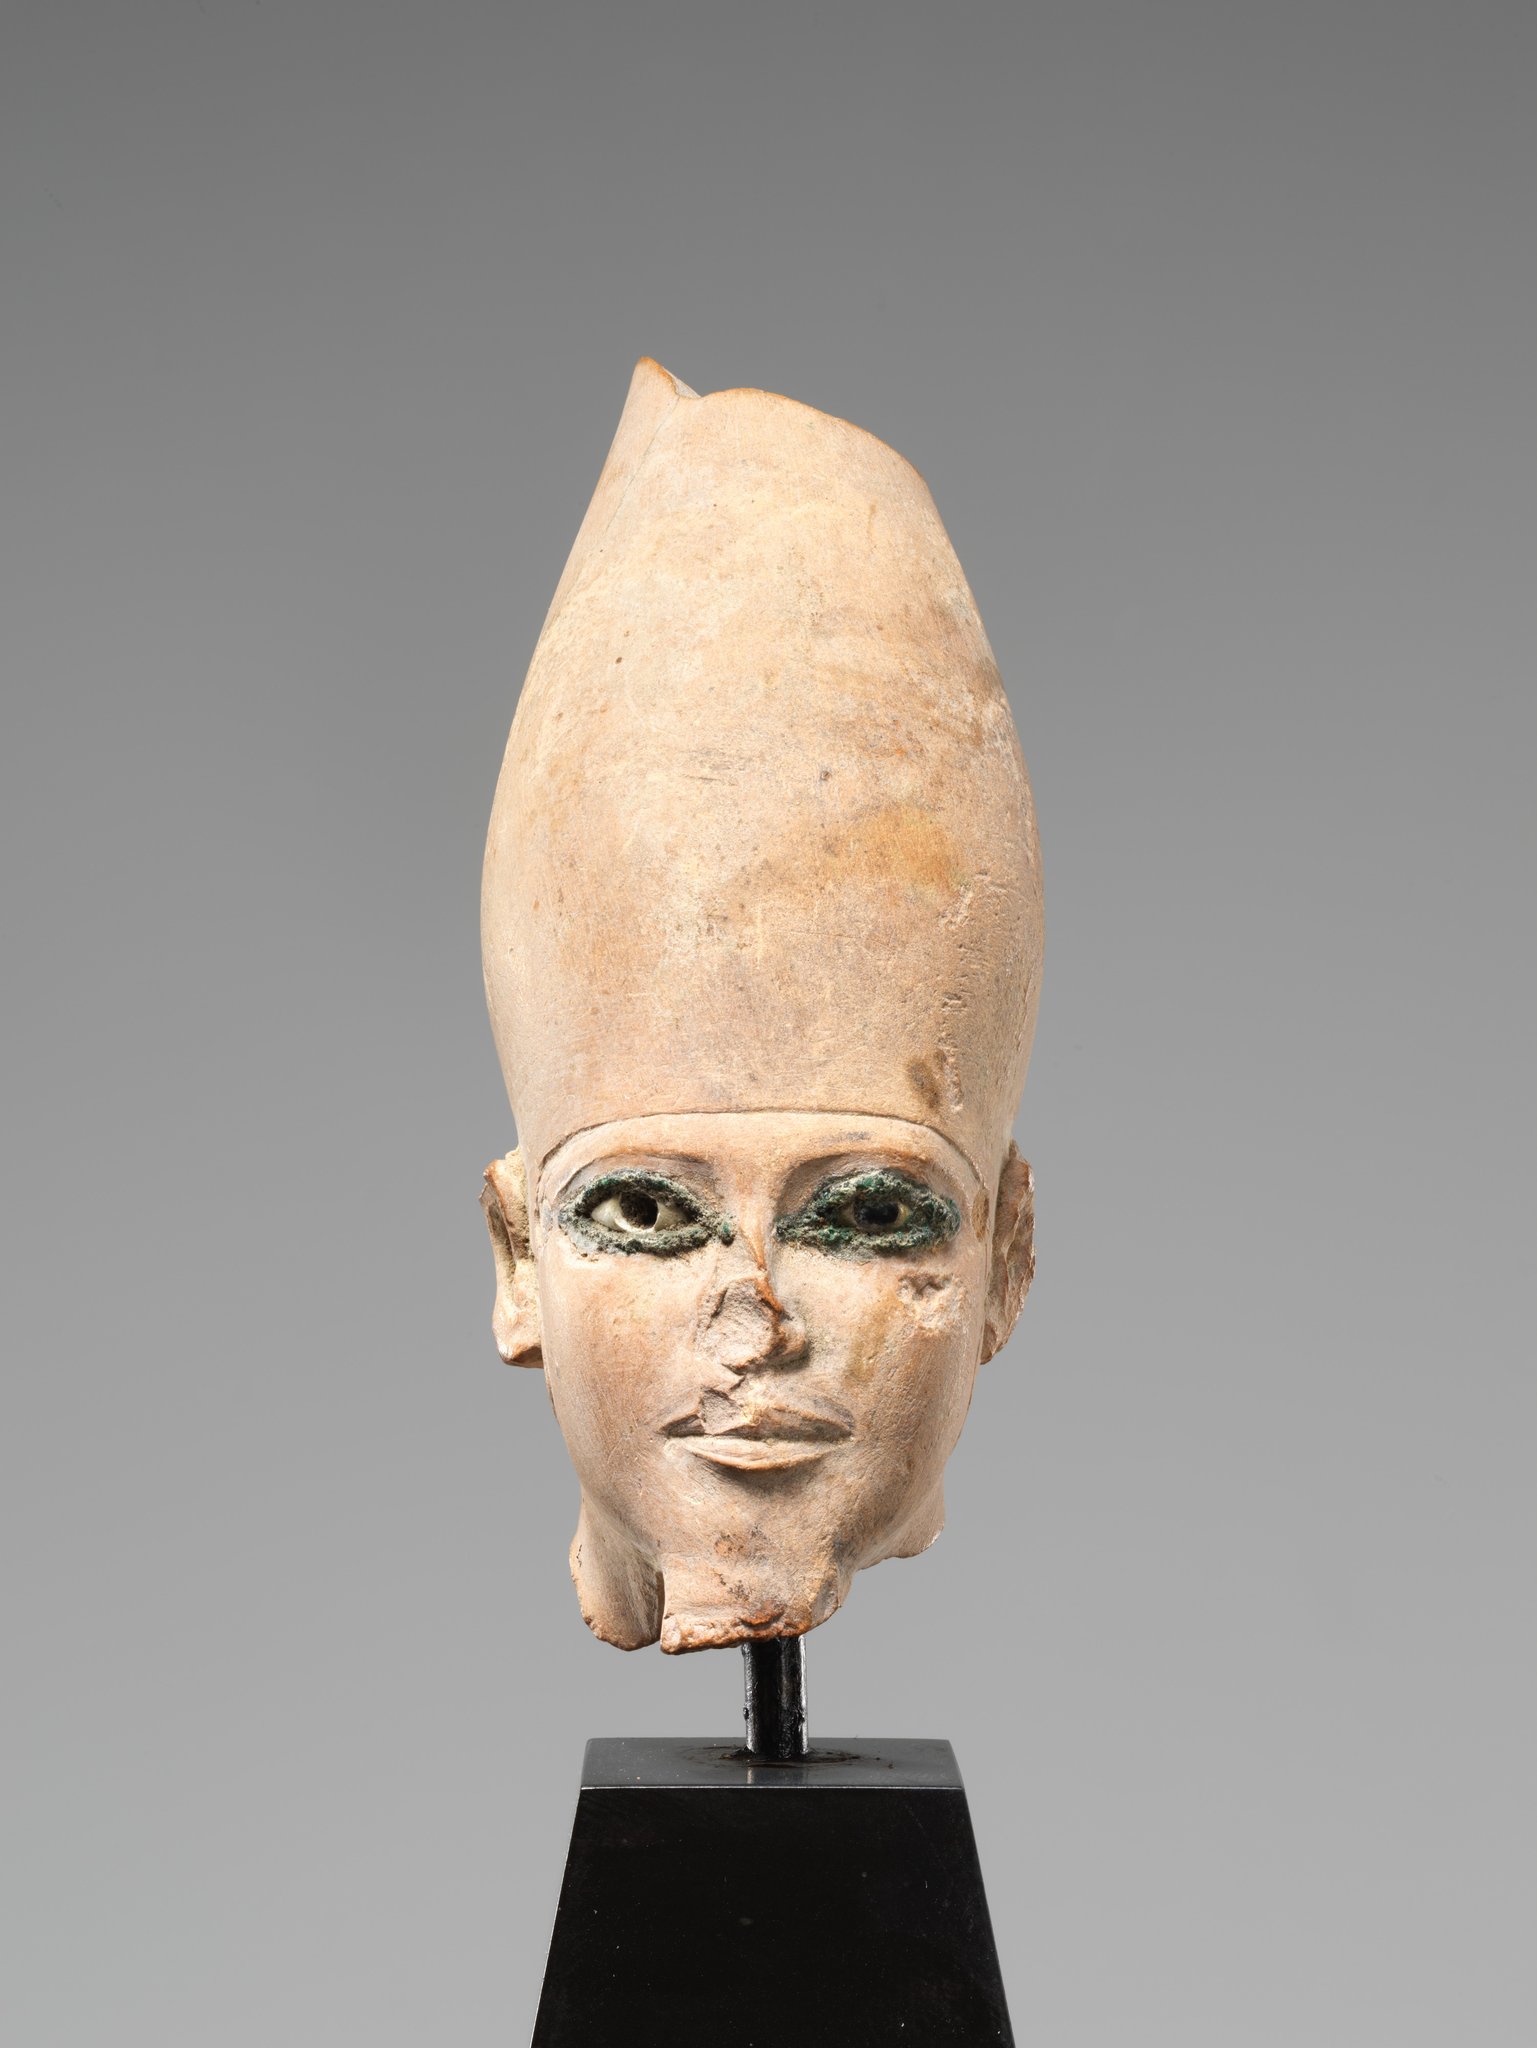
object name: head of a king, khafre, wearing the white crown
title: Head of a King, Probably Khafre, Wearing the White Crown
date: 2520-2494 BCE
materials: metal, limestone, obsidian, paint, stone